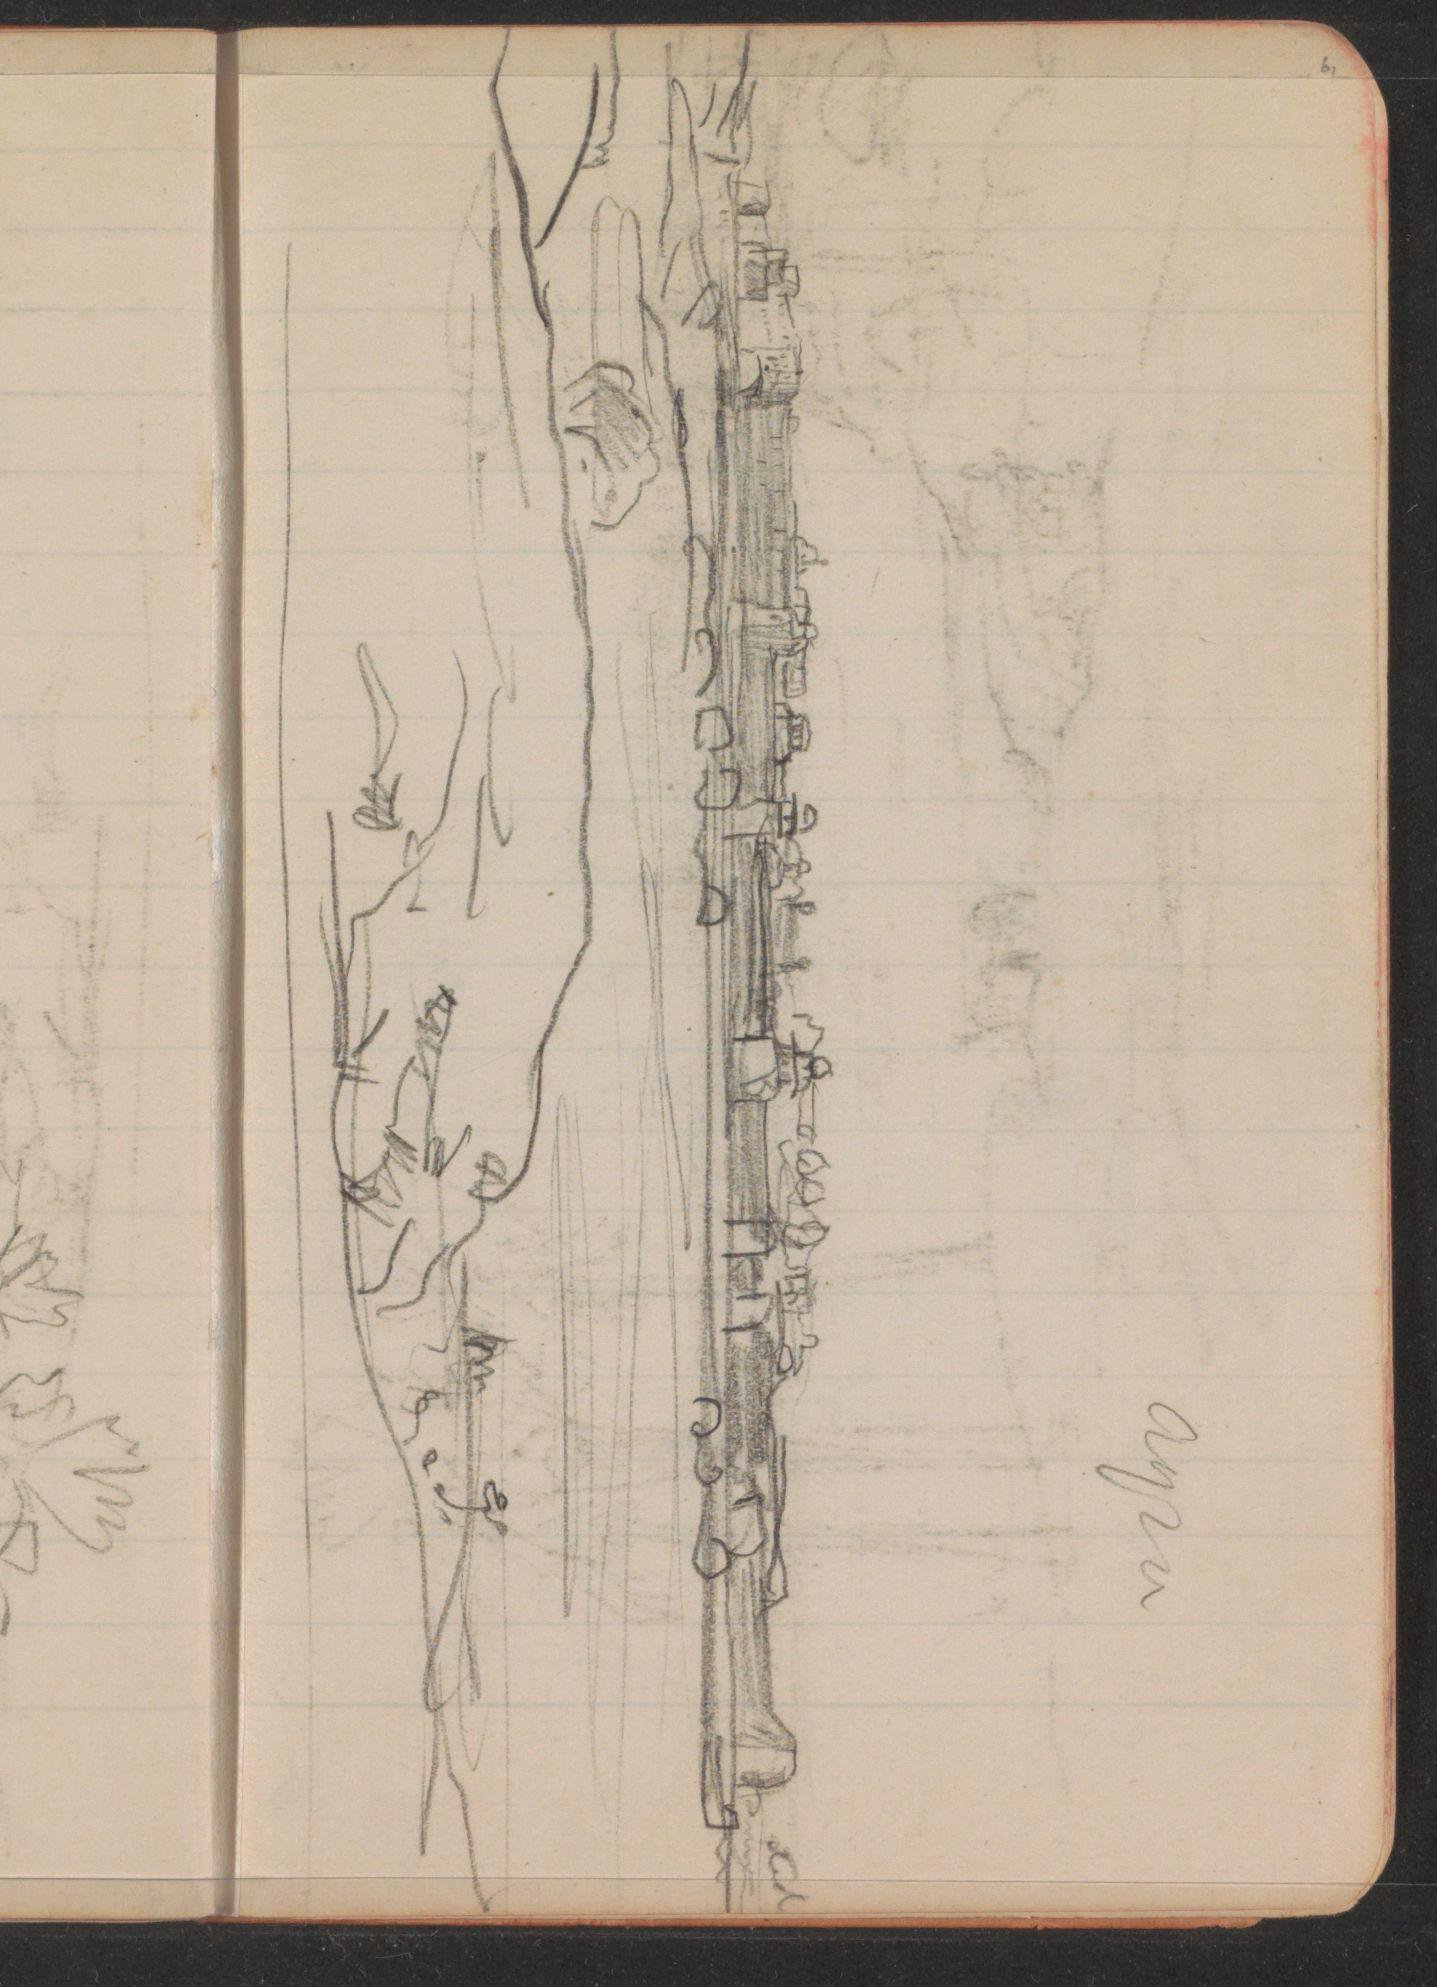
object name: sketchbook leaf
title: Gezicht op Agra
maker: marius bauer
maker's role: draughtsman, print maker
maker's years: 1867-1932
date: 1897-1898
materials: chalk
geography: agra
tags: city-view, and landscape with man-made constructions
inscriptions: annotation: ‘Agra/ stad’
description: Pagina 61 uit een schetsboek met 36 bladen.